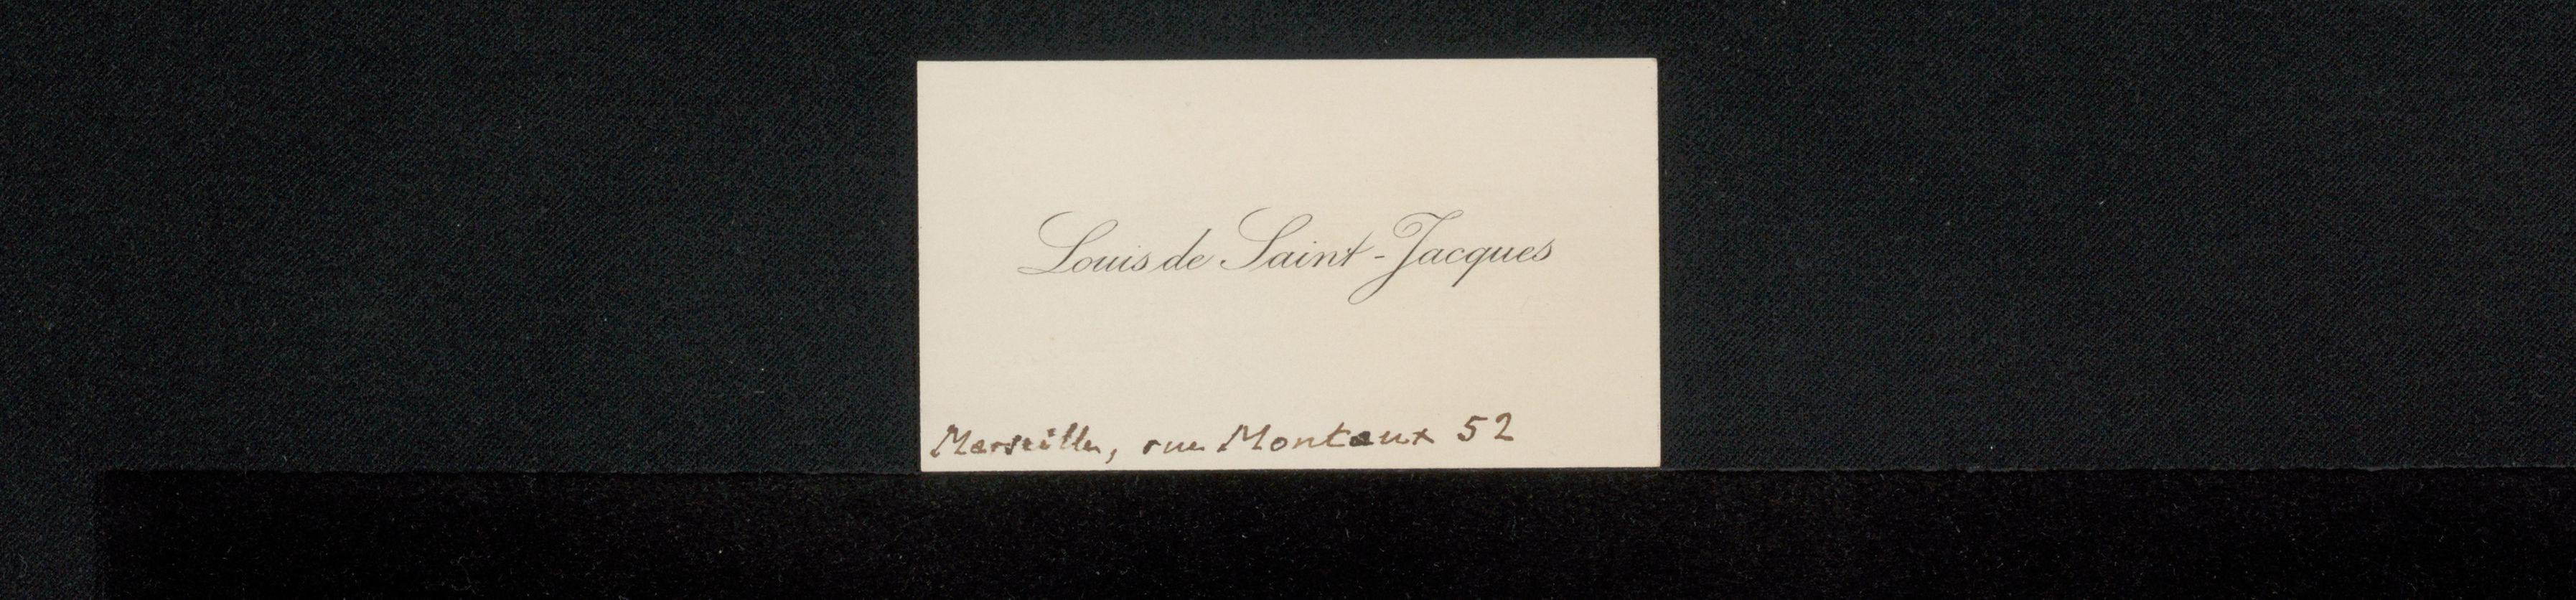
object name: visiting card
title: Visitekaartje aan Philip Zilcken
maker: louis de saint-jacques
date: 1867-1930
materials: cardboard, ink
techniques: pen, printing, writing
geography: marseille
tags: the hague, painter, draughtsman, philip zilcken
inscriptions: collector's mark: ‘RPK’